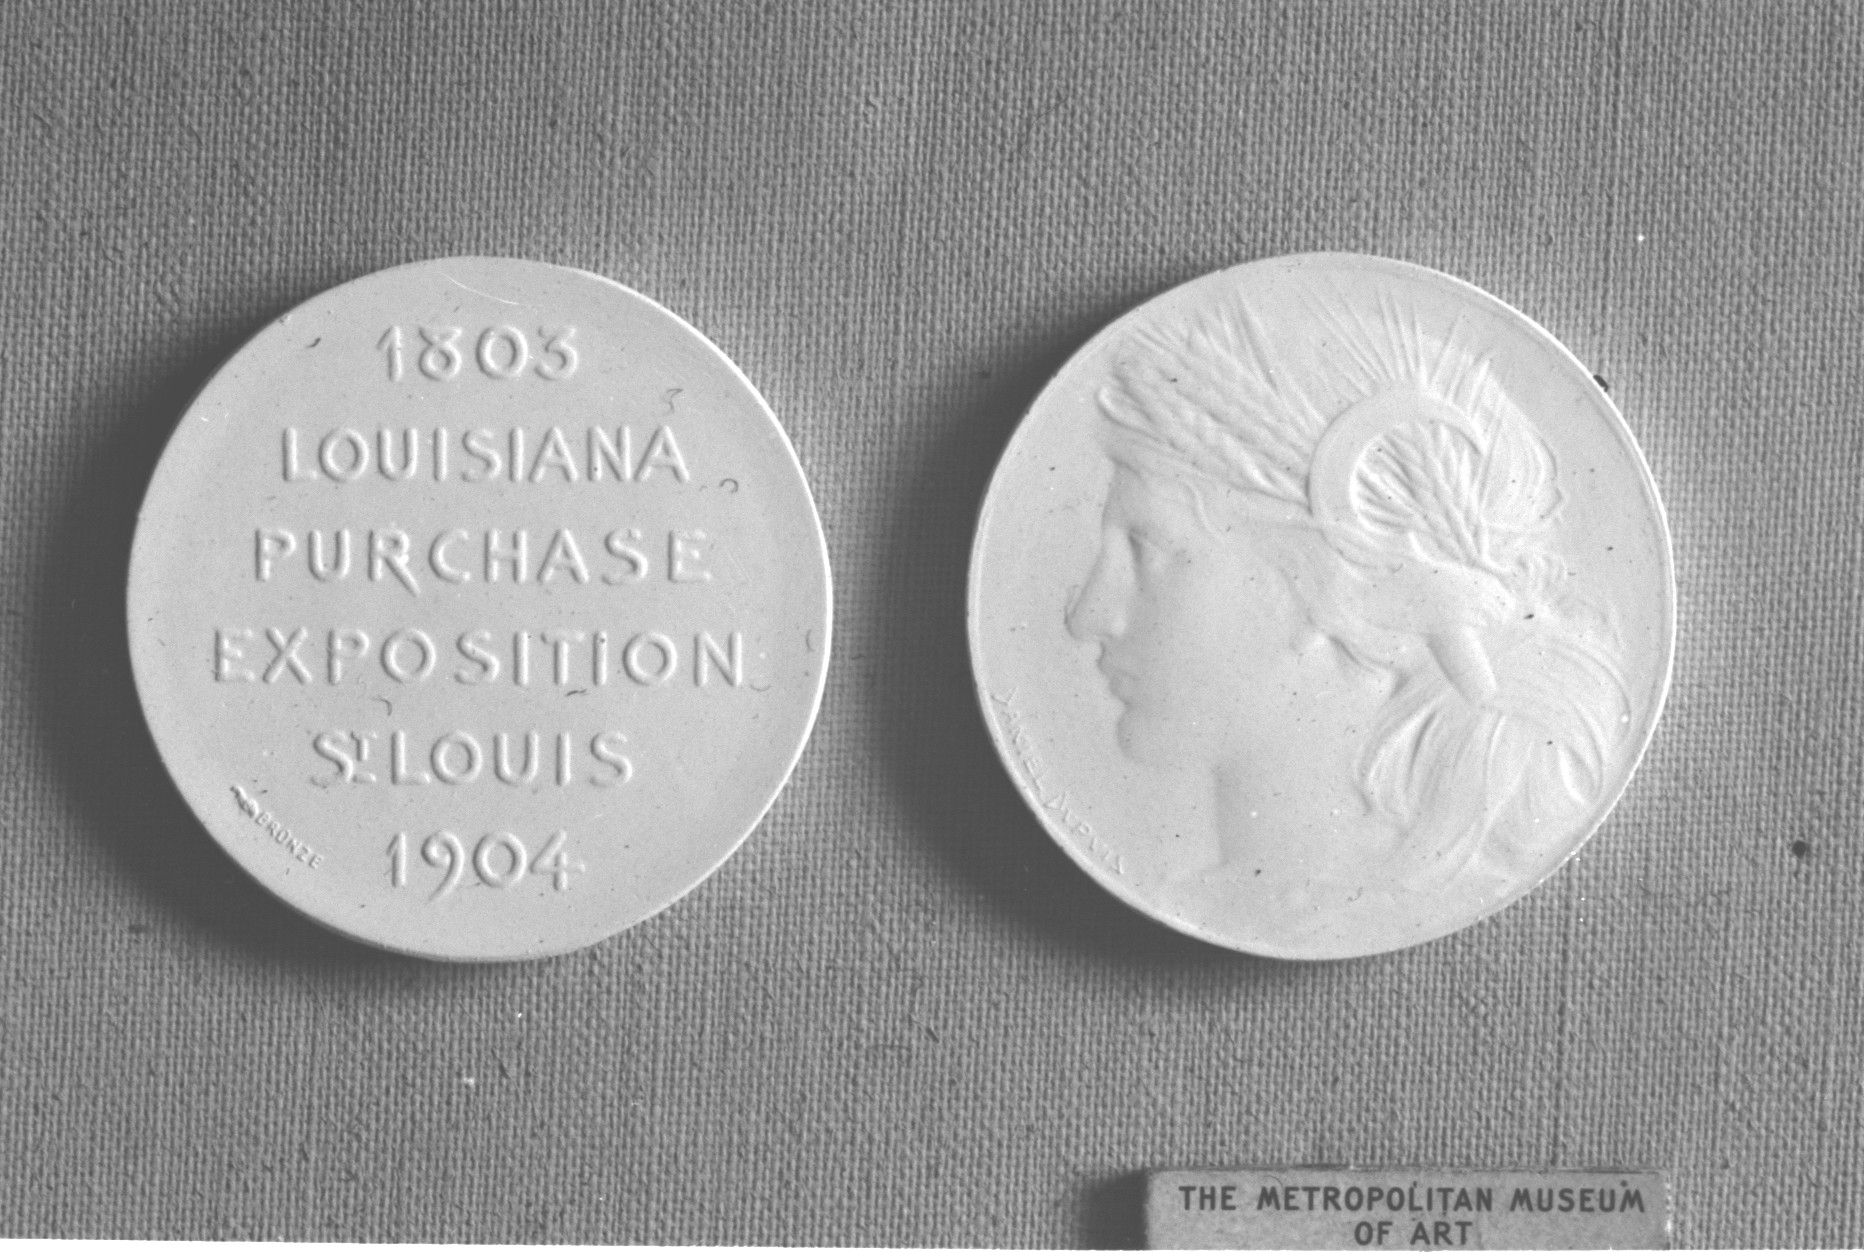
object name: token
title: Agriculture (for the St. Louis Exposition, 1904)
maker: daniel jean-baptiste dupuis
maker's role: artist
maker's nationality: french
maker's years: 1849-1899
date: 1904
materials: bronze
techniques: struck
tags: profiles